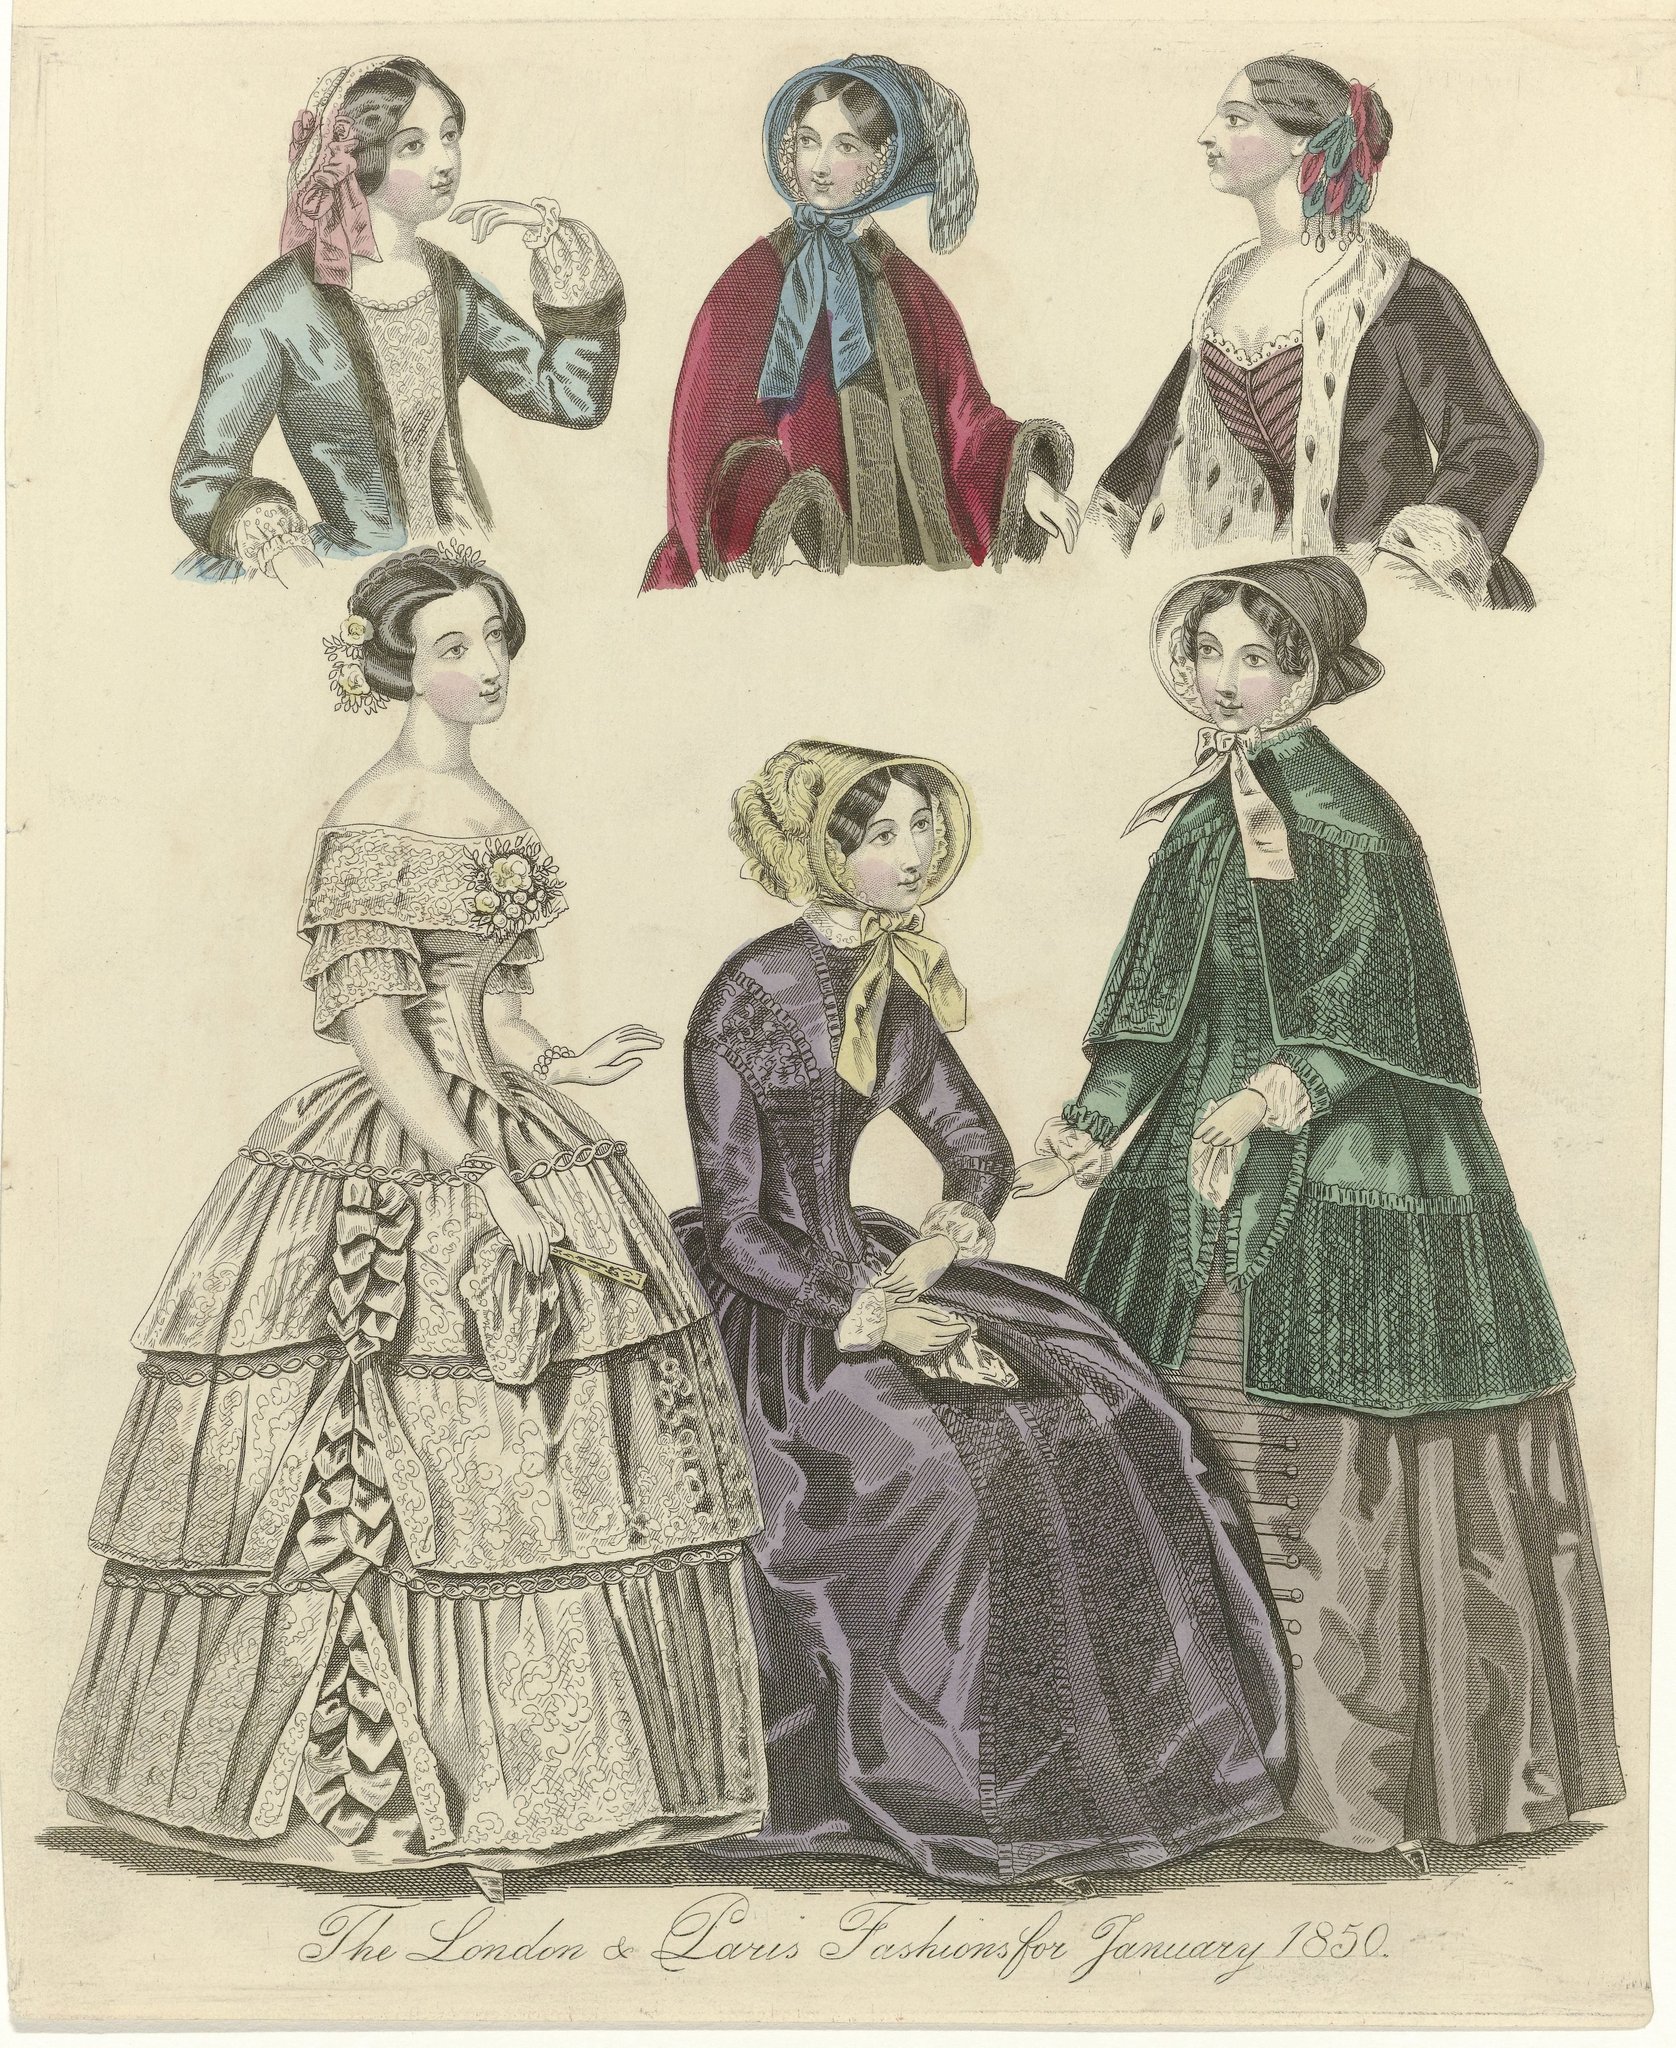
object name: fashion print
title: The World of Fashion, january 1850 : The London & Paris Fashions (...)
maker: Anonymous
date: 1850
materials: paper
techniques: etching, hand coloring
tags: handkerchief (+ women's clothes), dress, gown: evening dress (+ women's clothes), gloves, mittens (long gloves) (+ women's clothes), border, ribbon, braid (+ fur used for clothes), coat (+ women's clothes), head-gear: cap (+ women's clothes), fashion plates, head-gear: hat (+ women's clothes), fan (+ women's clothes)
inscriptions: caption: ‘The London & Paris Fashions for January 1850.’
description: Modes voor januari 1850 uit Londen en Parijs. Avondjapon met puntig lijfje en wijde rok, versierd met drie geplooide stroken stof. Japon met lange mouwen en geplooide ondermouwen. Mantels, afgezet met bont of hermelijn. Accessoires: hoeden, muts, bloemcorsage, handschoenen, zakdoek, waaier. Prent uit het modetijdschrift The World of Fashion (1824-1891).